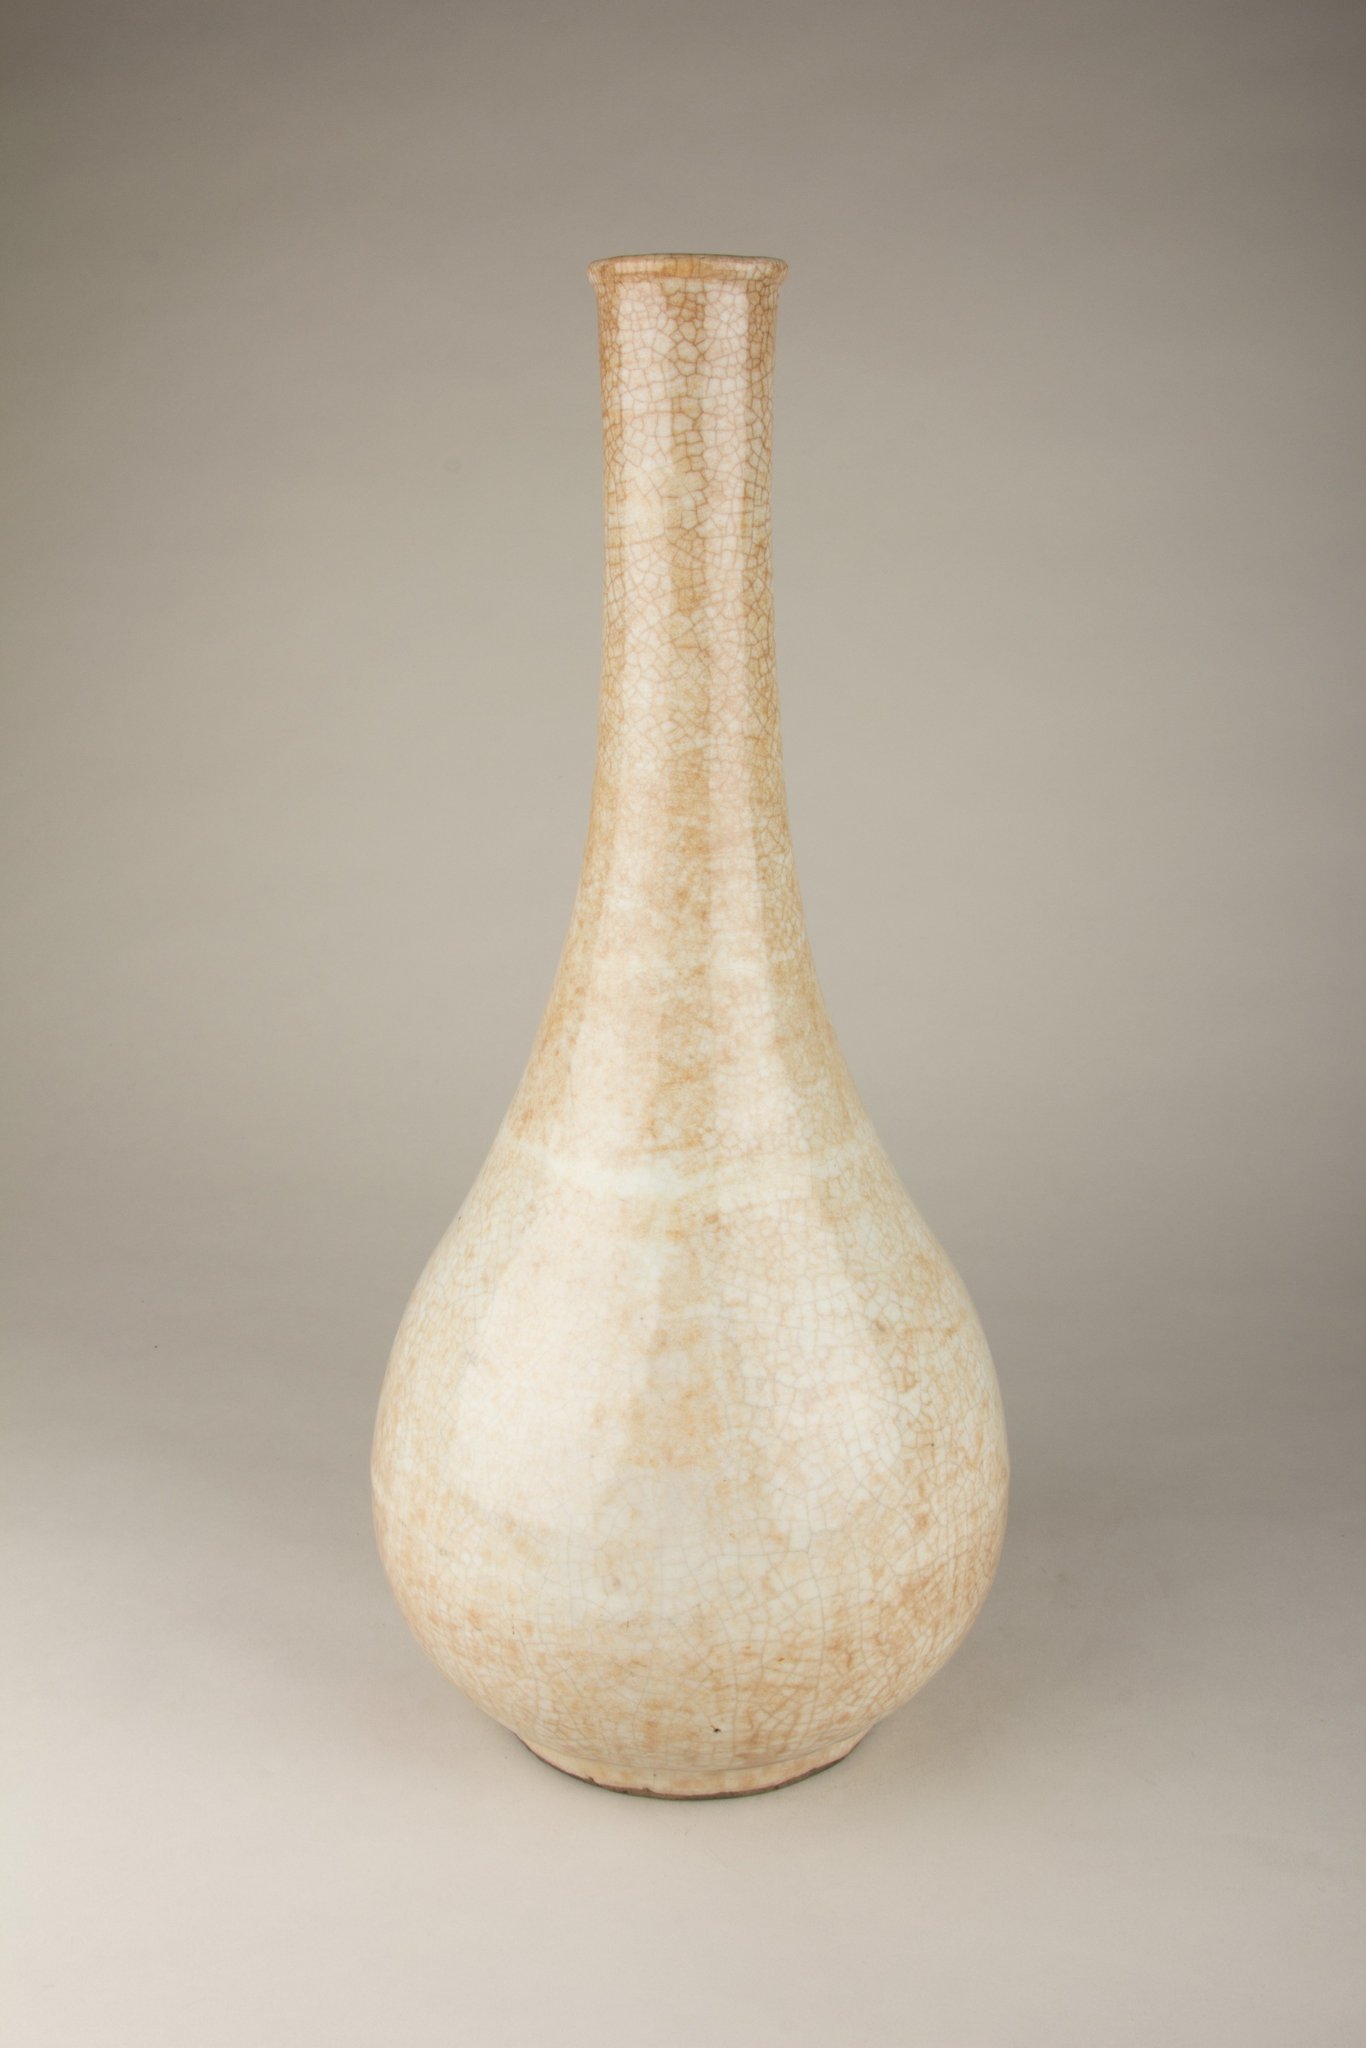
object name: bottle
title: Long neck bottle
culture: chinese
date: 1301-1500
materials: glaze, porcelain